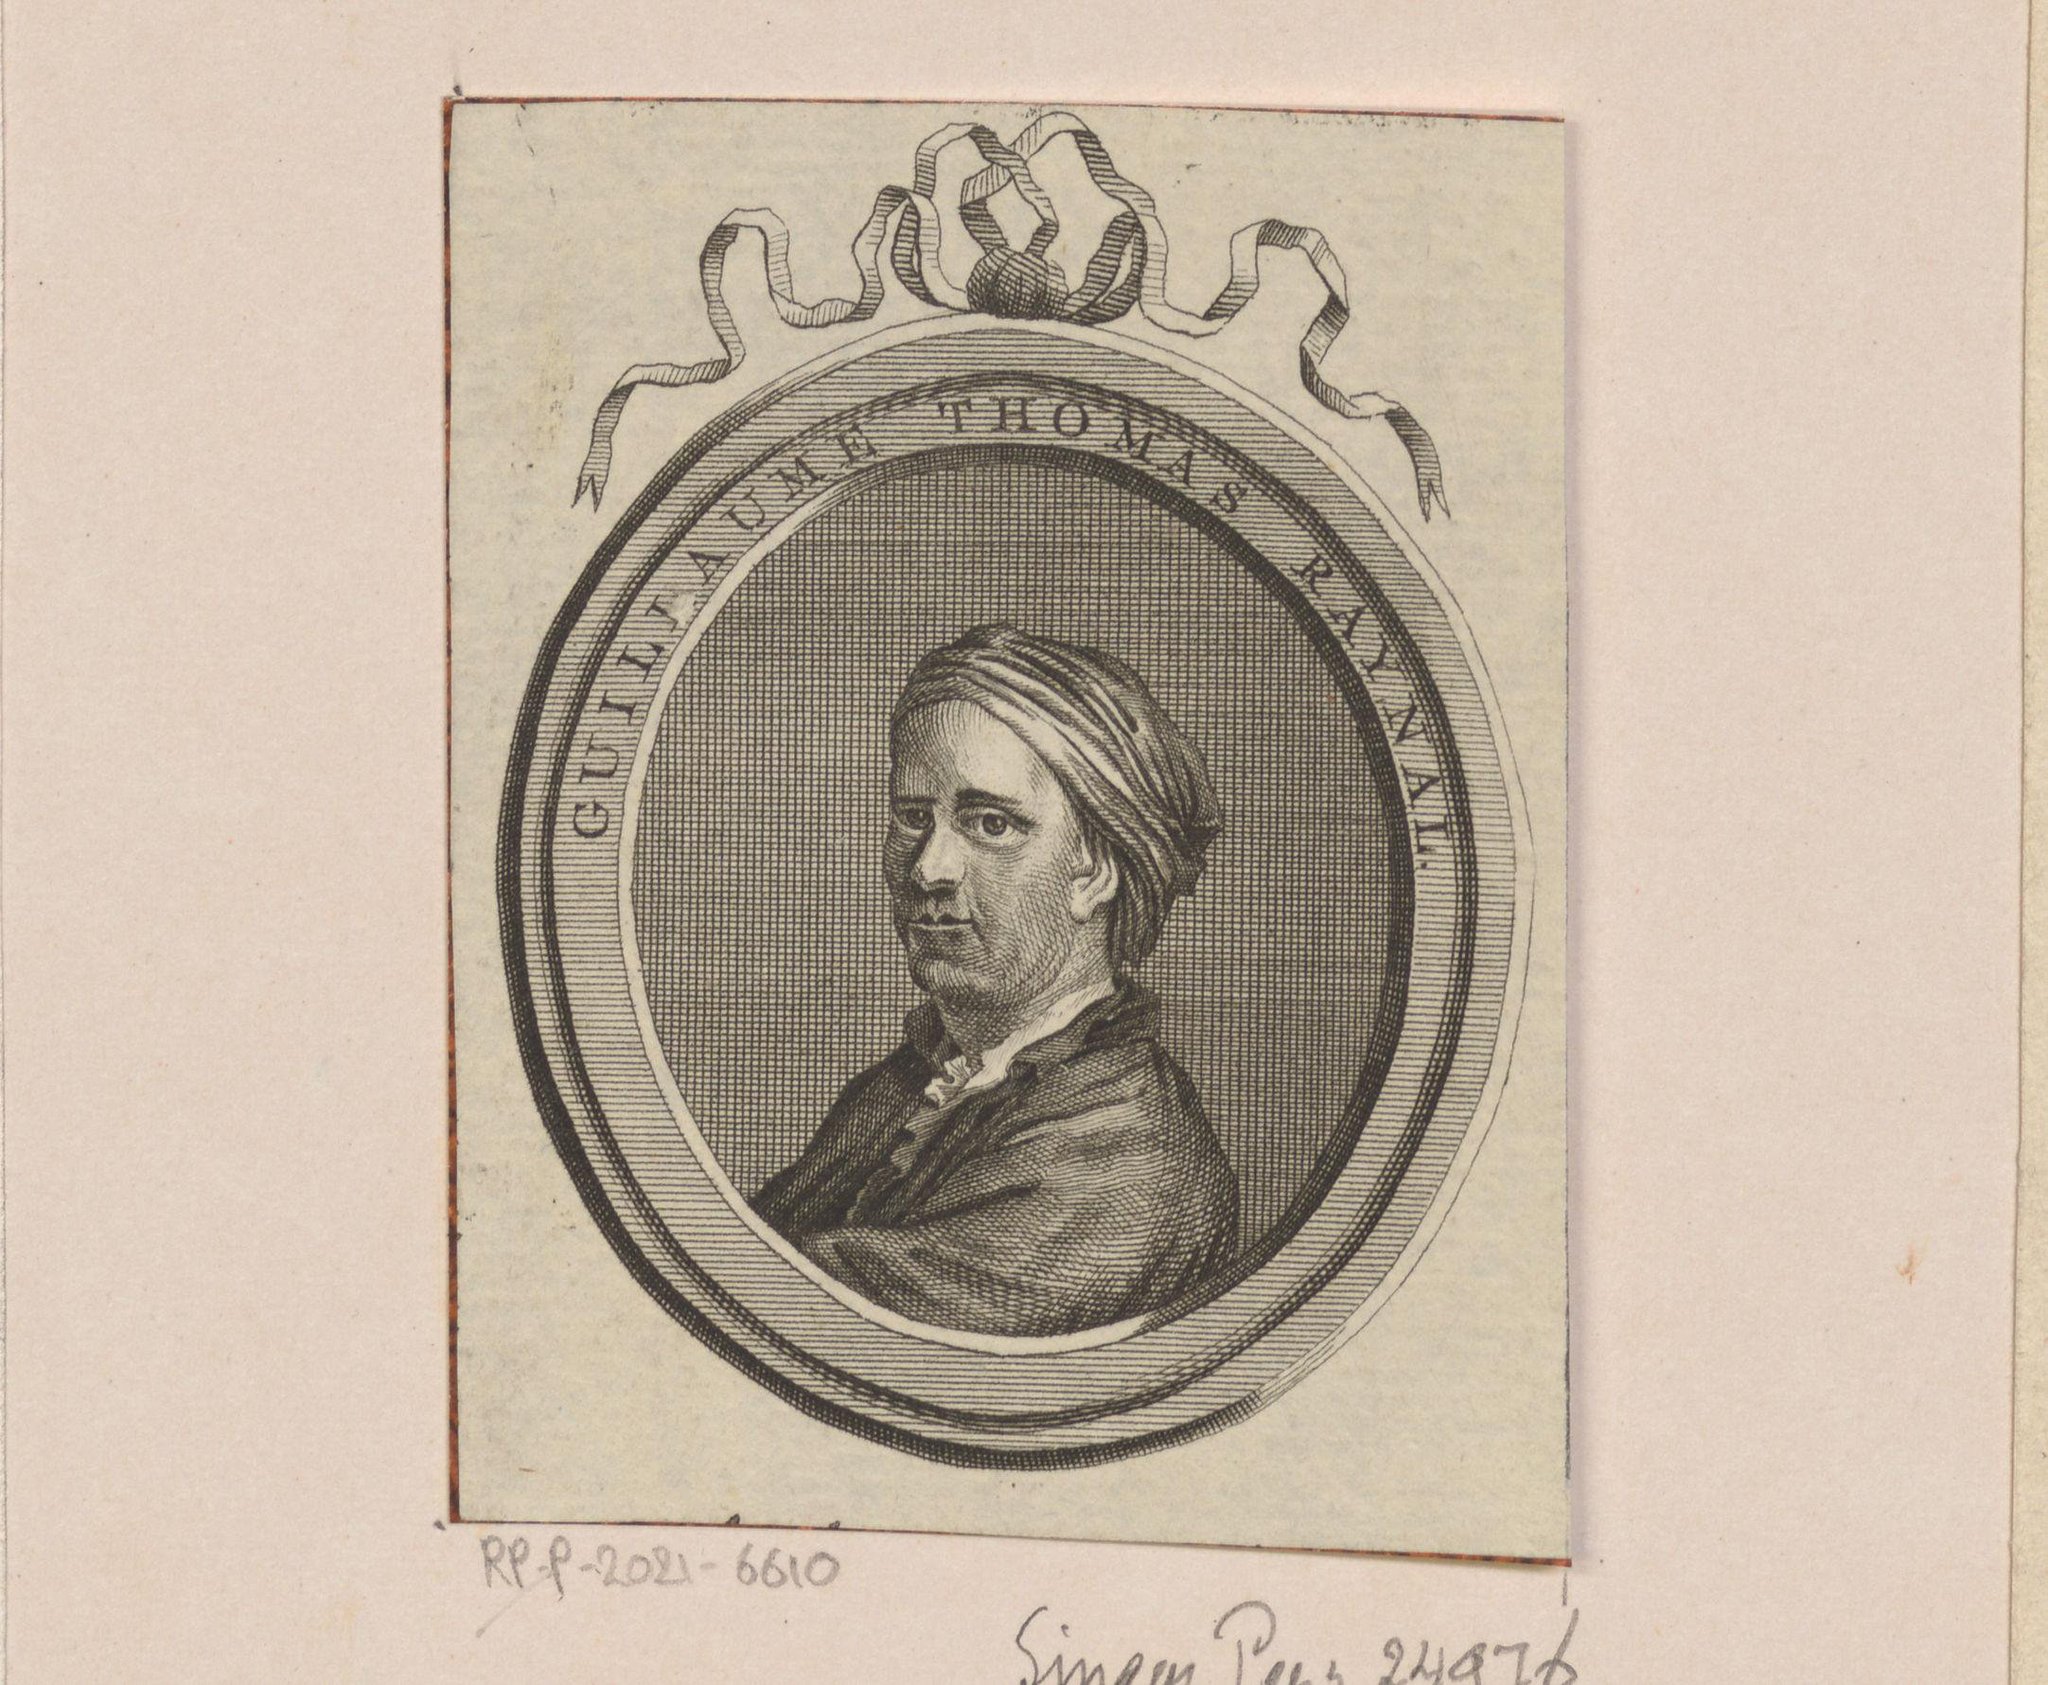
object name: print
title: Portret van Guillaume-Thomas François Raynal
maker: Anonymous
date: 1750-1849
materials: paper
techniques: engraving, etching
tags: historical persons